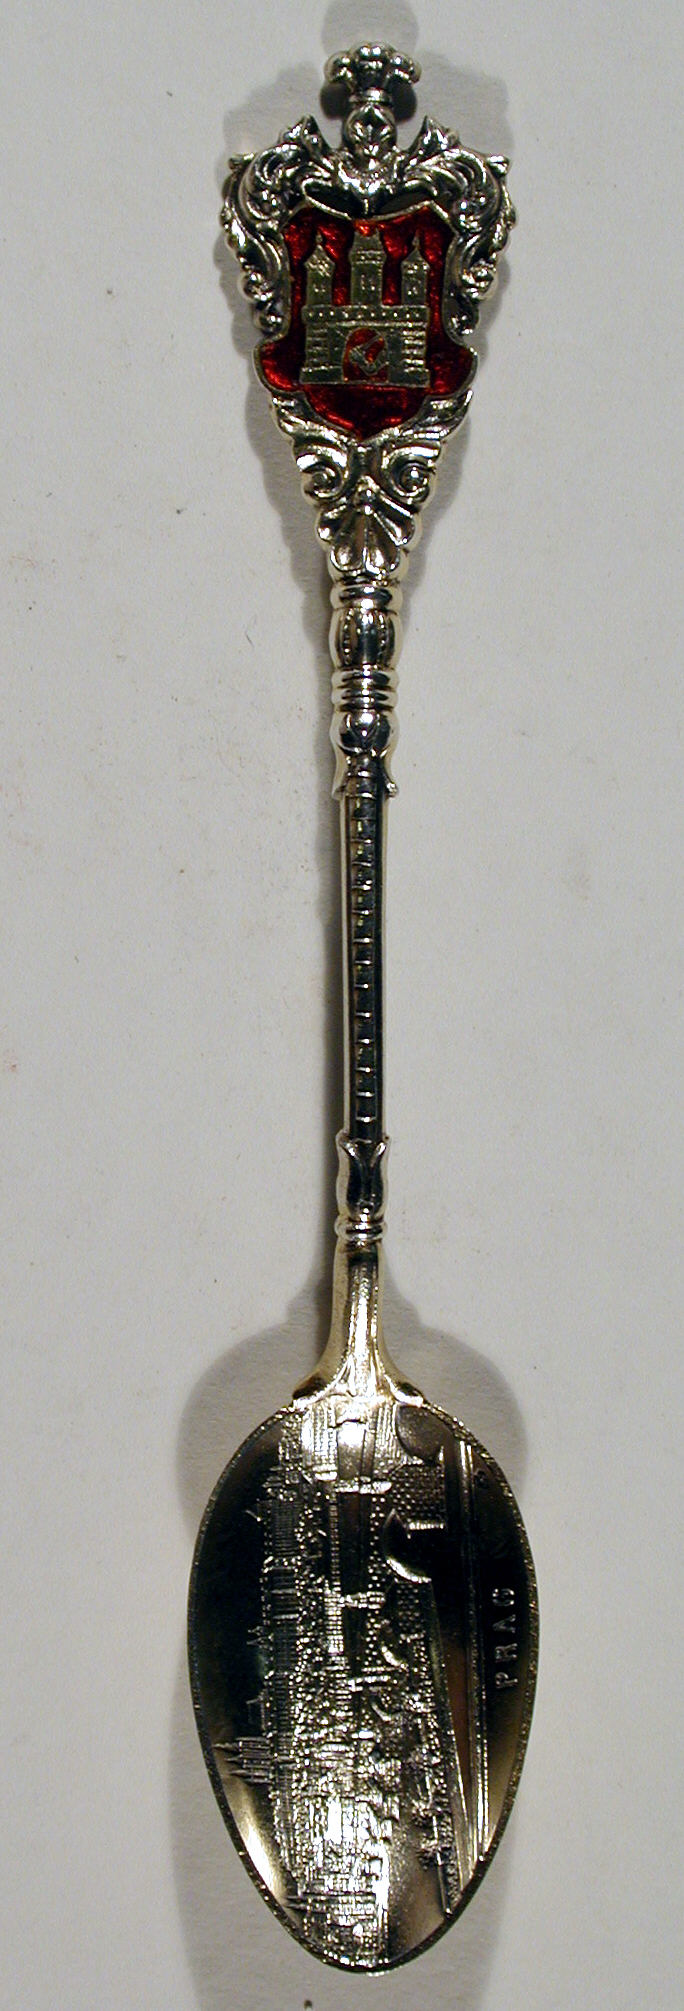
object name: souvenir spoon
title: Souvenir spoon with view of Prague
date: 1867-1900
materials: enamel, silver gilt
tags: cities,bridges